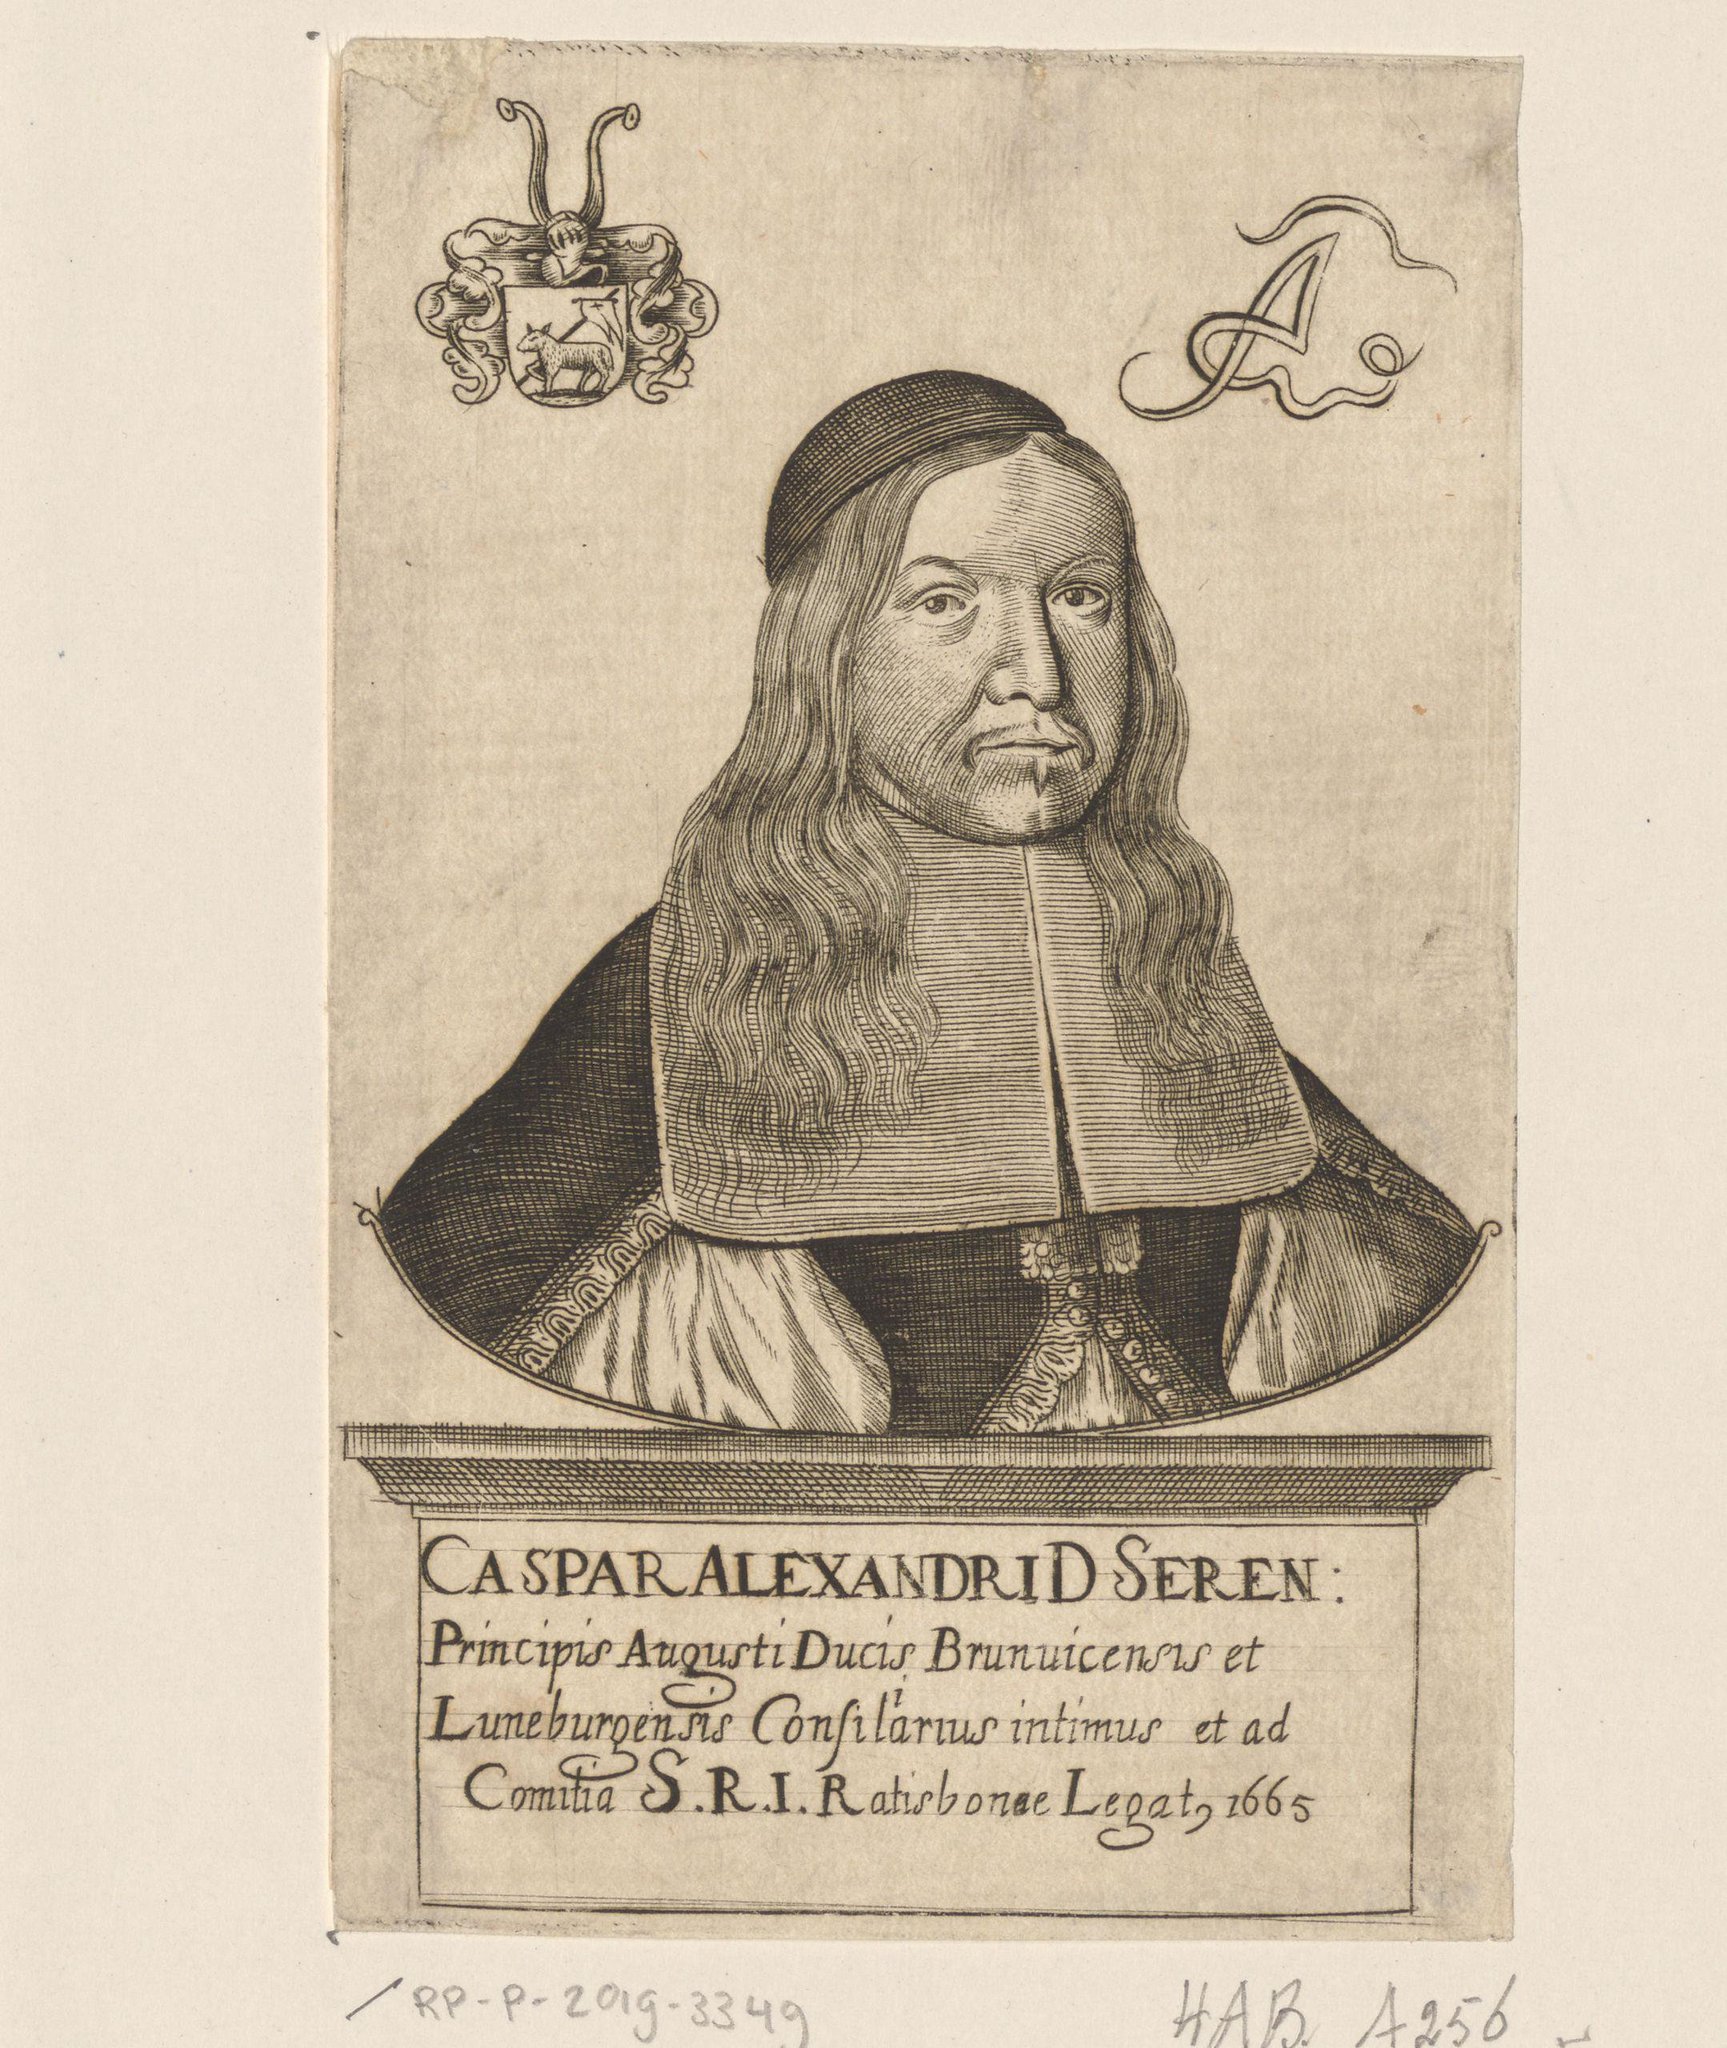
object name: print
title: Portret van Caspar Alexandri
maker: Anonymous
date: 1650-1699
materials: paper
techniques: engraving, etching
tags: historical persons, armorial bearing, heraldry